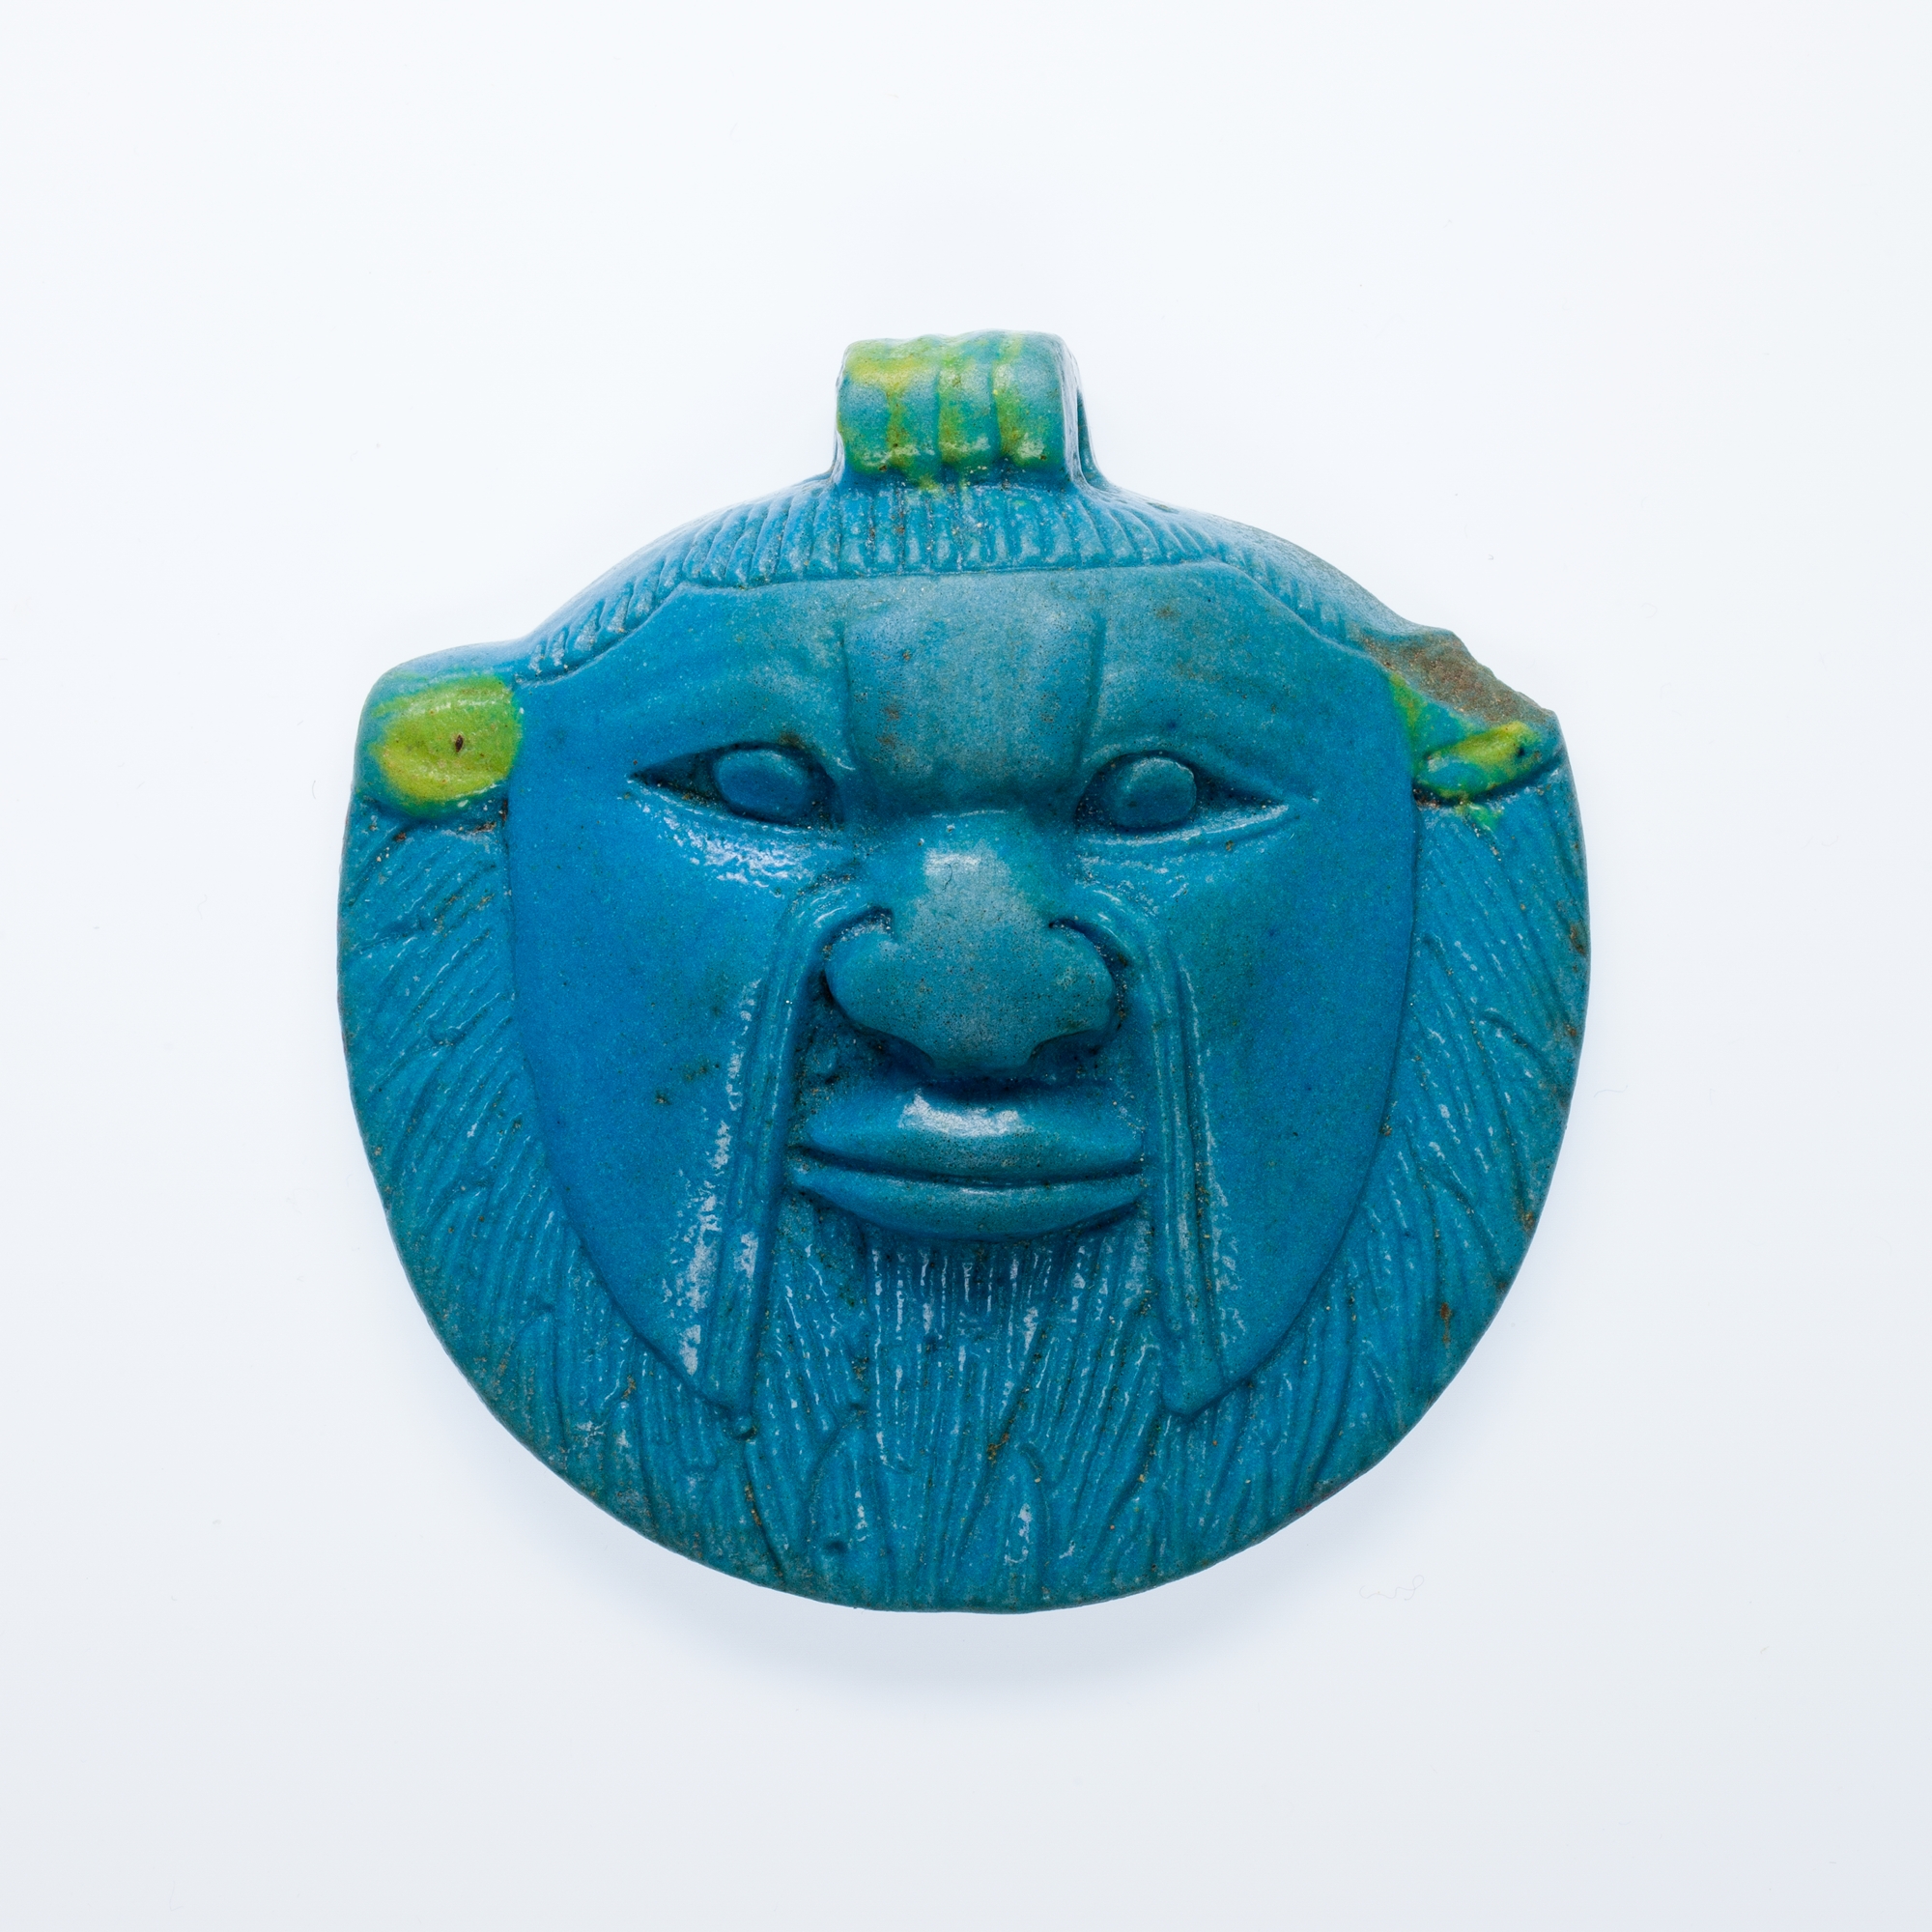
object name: amulet, be head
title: Amulet of the Head of Bes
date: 664-332 BCE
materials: faience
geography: egypt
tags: bes